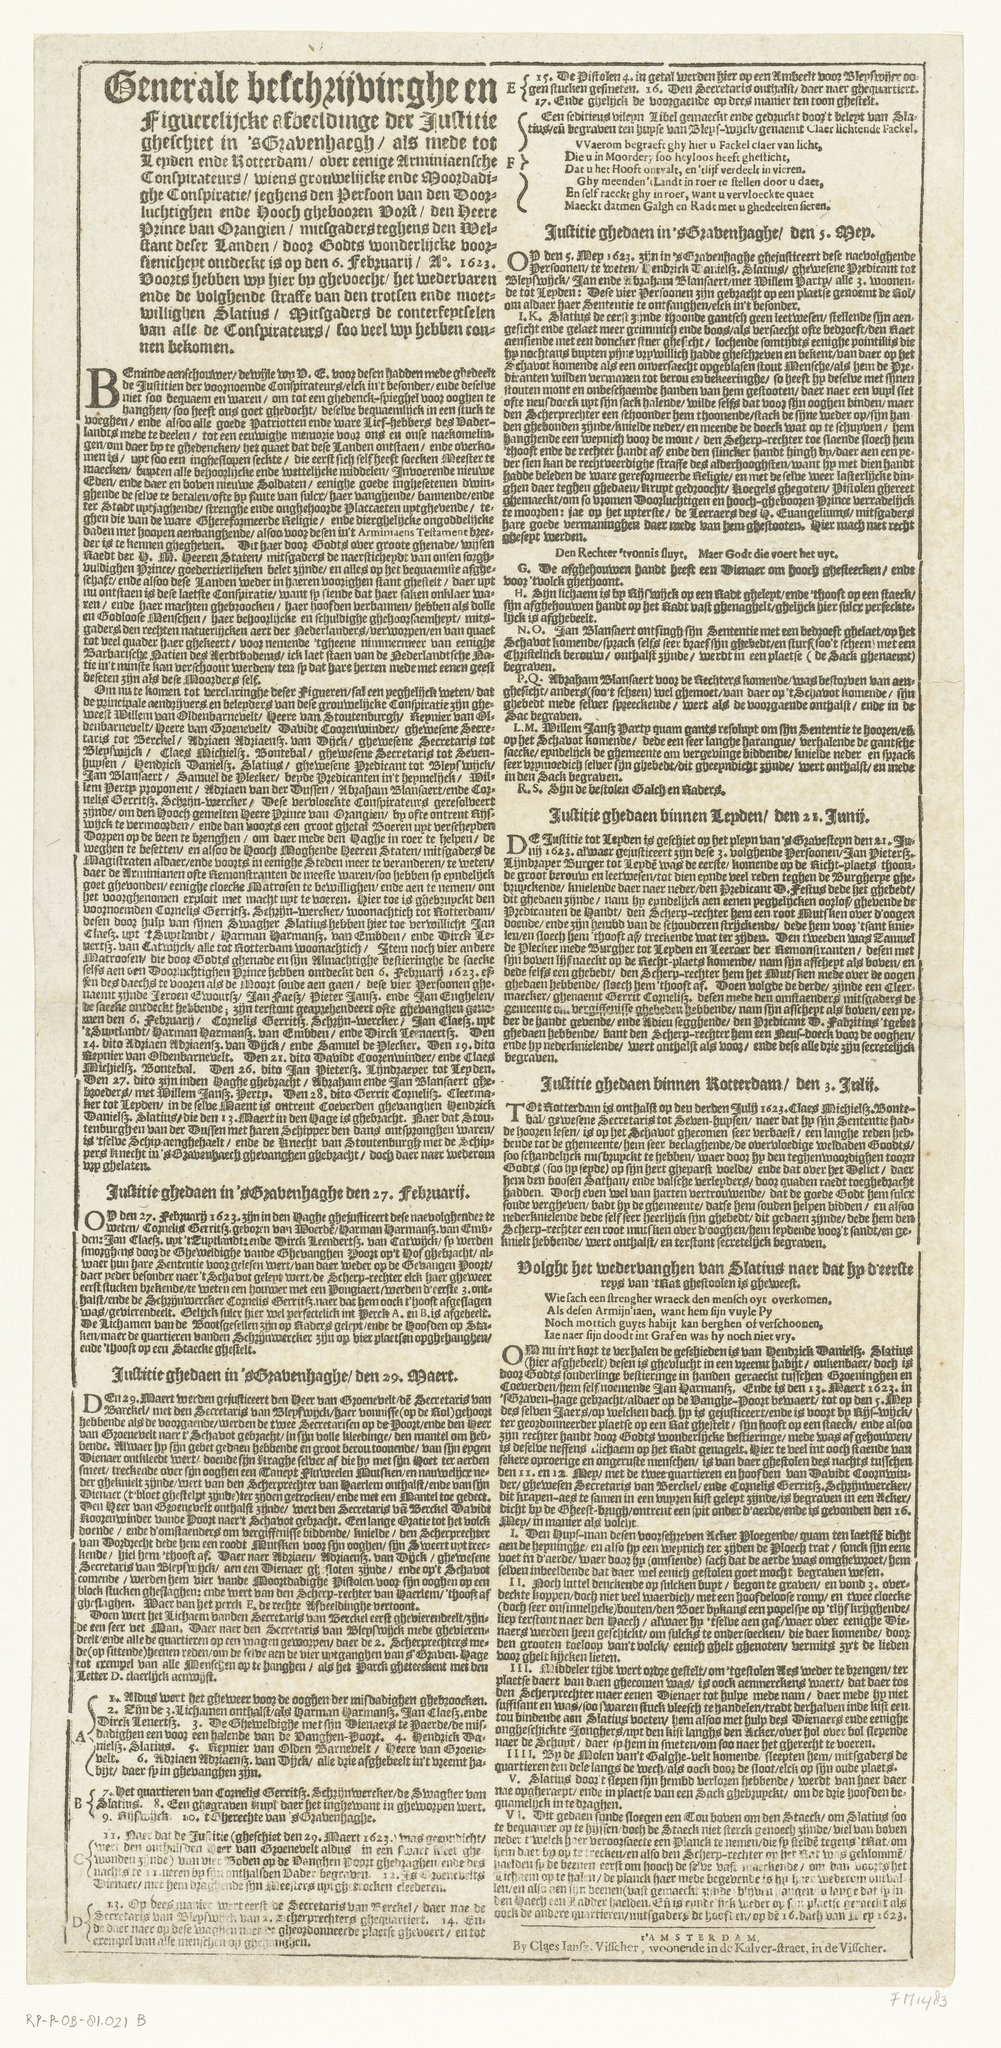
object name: text sheet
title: Tekstblad bij de grote prent van de terechtstelling van de samenzweerders tegen Maurits, 1623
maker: claes jansz. visscher (ii)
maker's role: draughtsman, print maker, publisher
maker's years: 1586-1652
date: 1623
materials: paper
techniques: letterpress printing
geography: amsterdam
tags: the hague, maurice (prince of orange), leiden, (revolutionary) plot, conspiracy, on the scaffold or place of execution, mutilation of the corpse, violent death by beheading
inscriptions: date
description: Tekstblad met het grotr blad met verschillende voorstellingen van de terechtstelling van de samenzweerders tegen Maurits, 27 februari, 29 maart en 5 mei 1623 te Den Haag en 21 juni te Leiden. Tekst in twee kolommen met verklaring van de letters A-S en de cijfers 1-17 en I-VI.